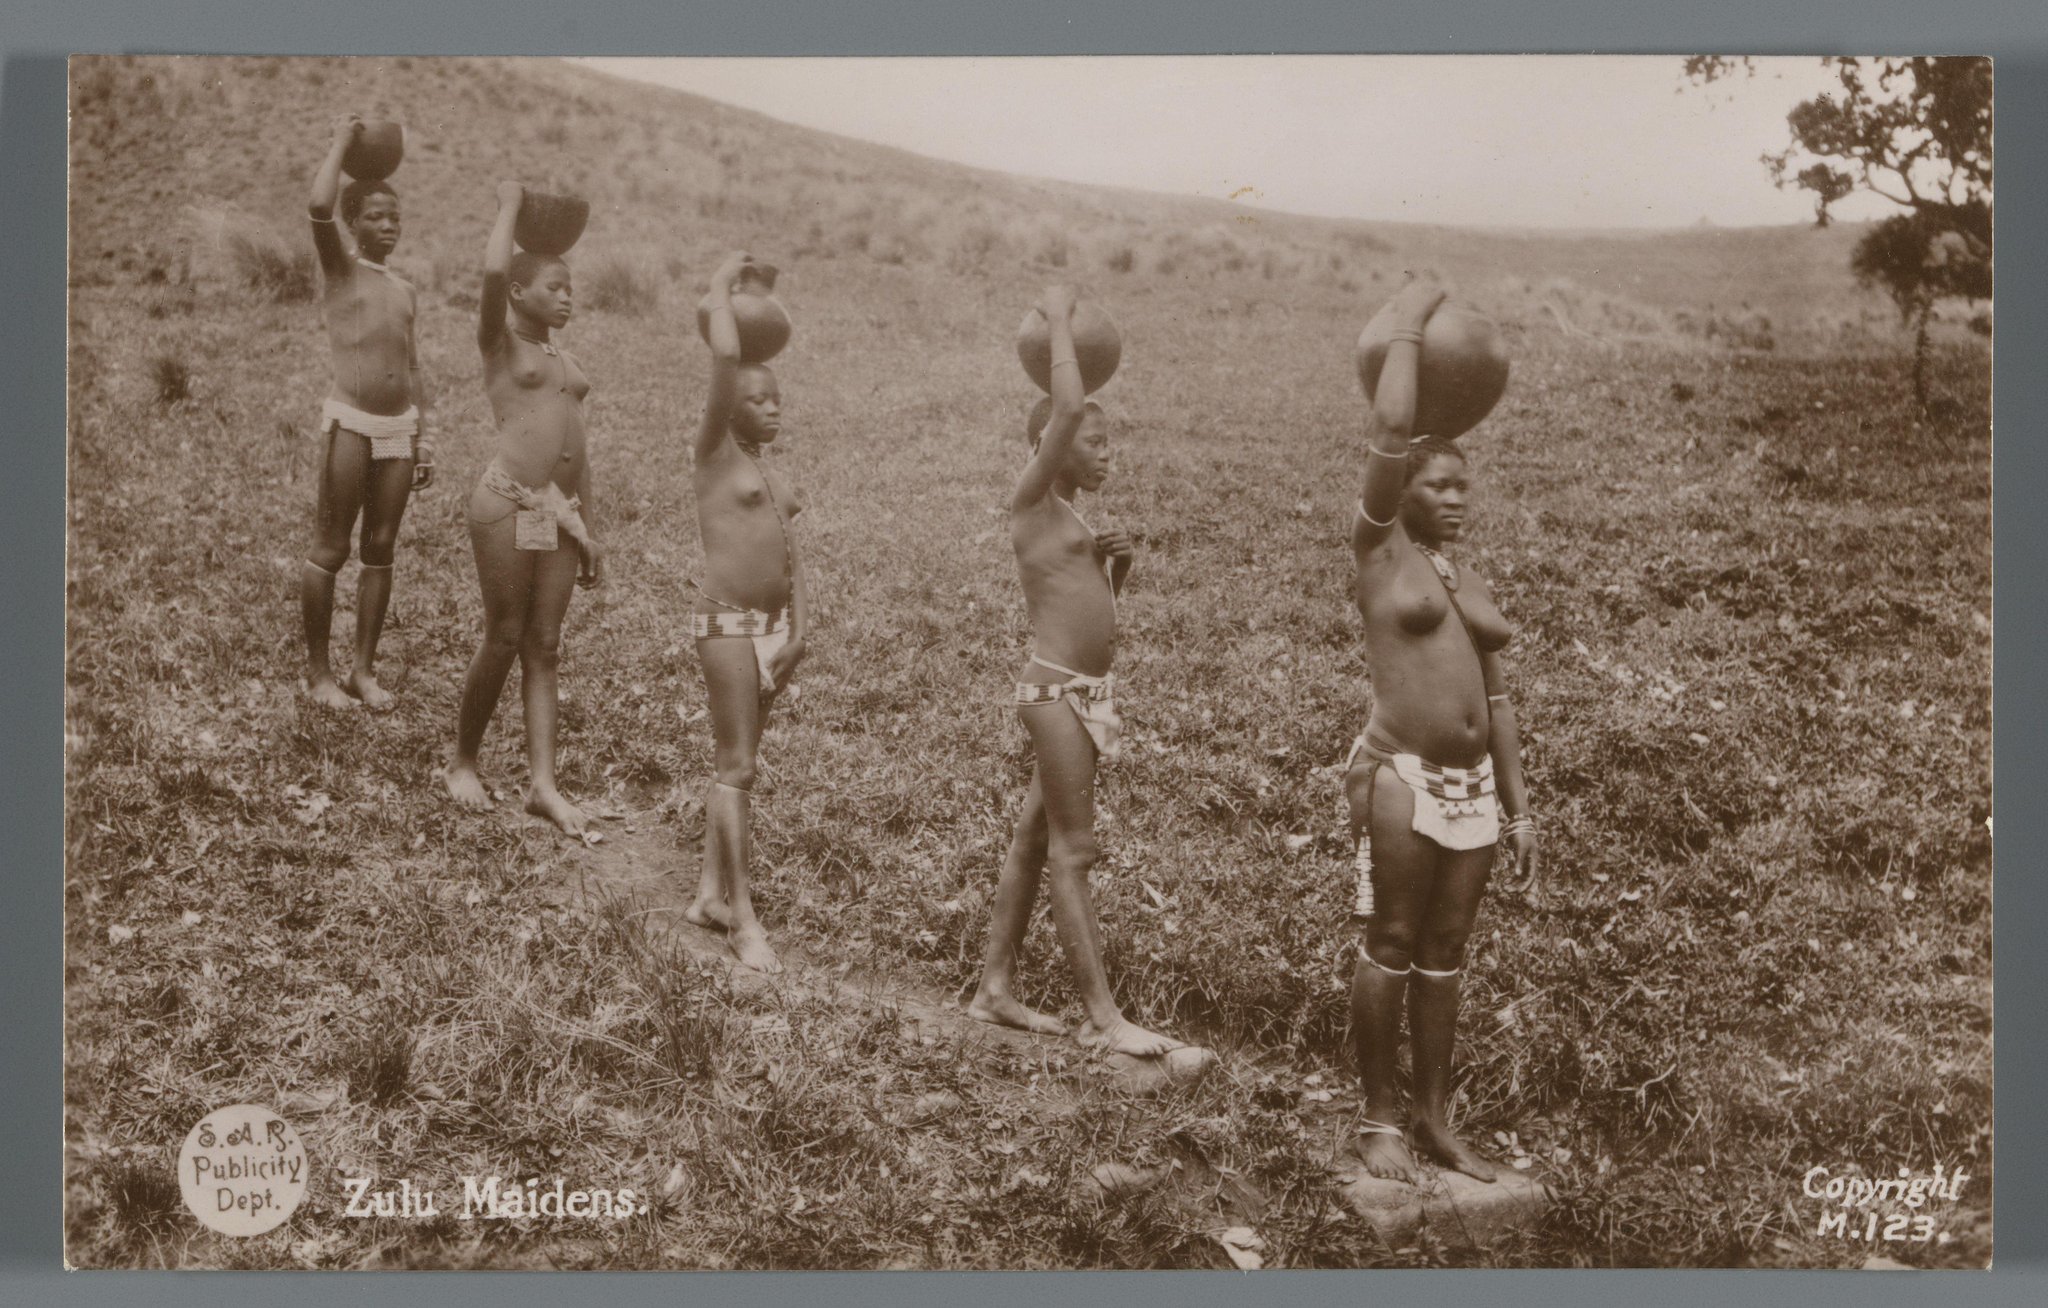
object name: photograph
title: Vijf Zoeloevrouwen met waterkruiken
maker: Anonymous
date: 1920-1930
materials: paper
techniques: gelatin silver print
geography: south africa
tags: adult woman, africans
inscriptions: inscription: ‘Copyright/ M. 123.’